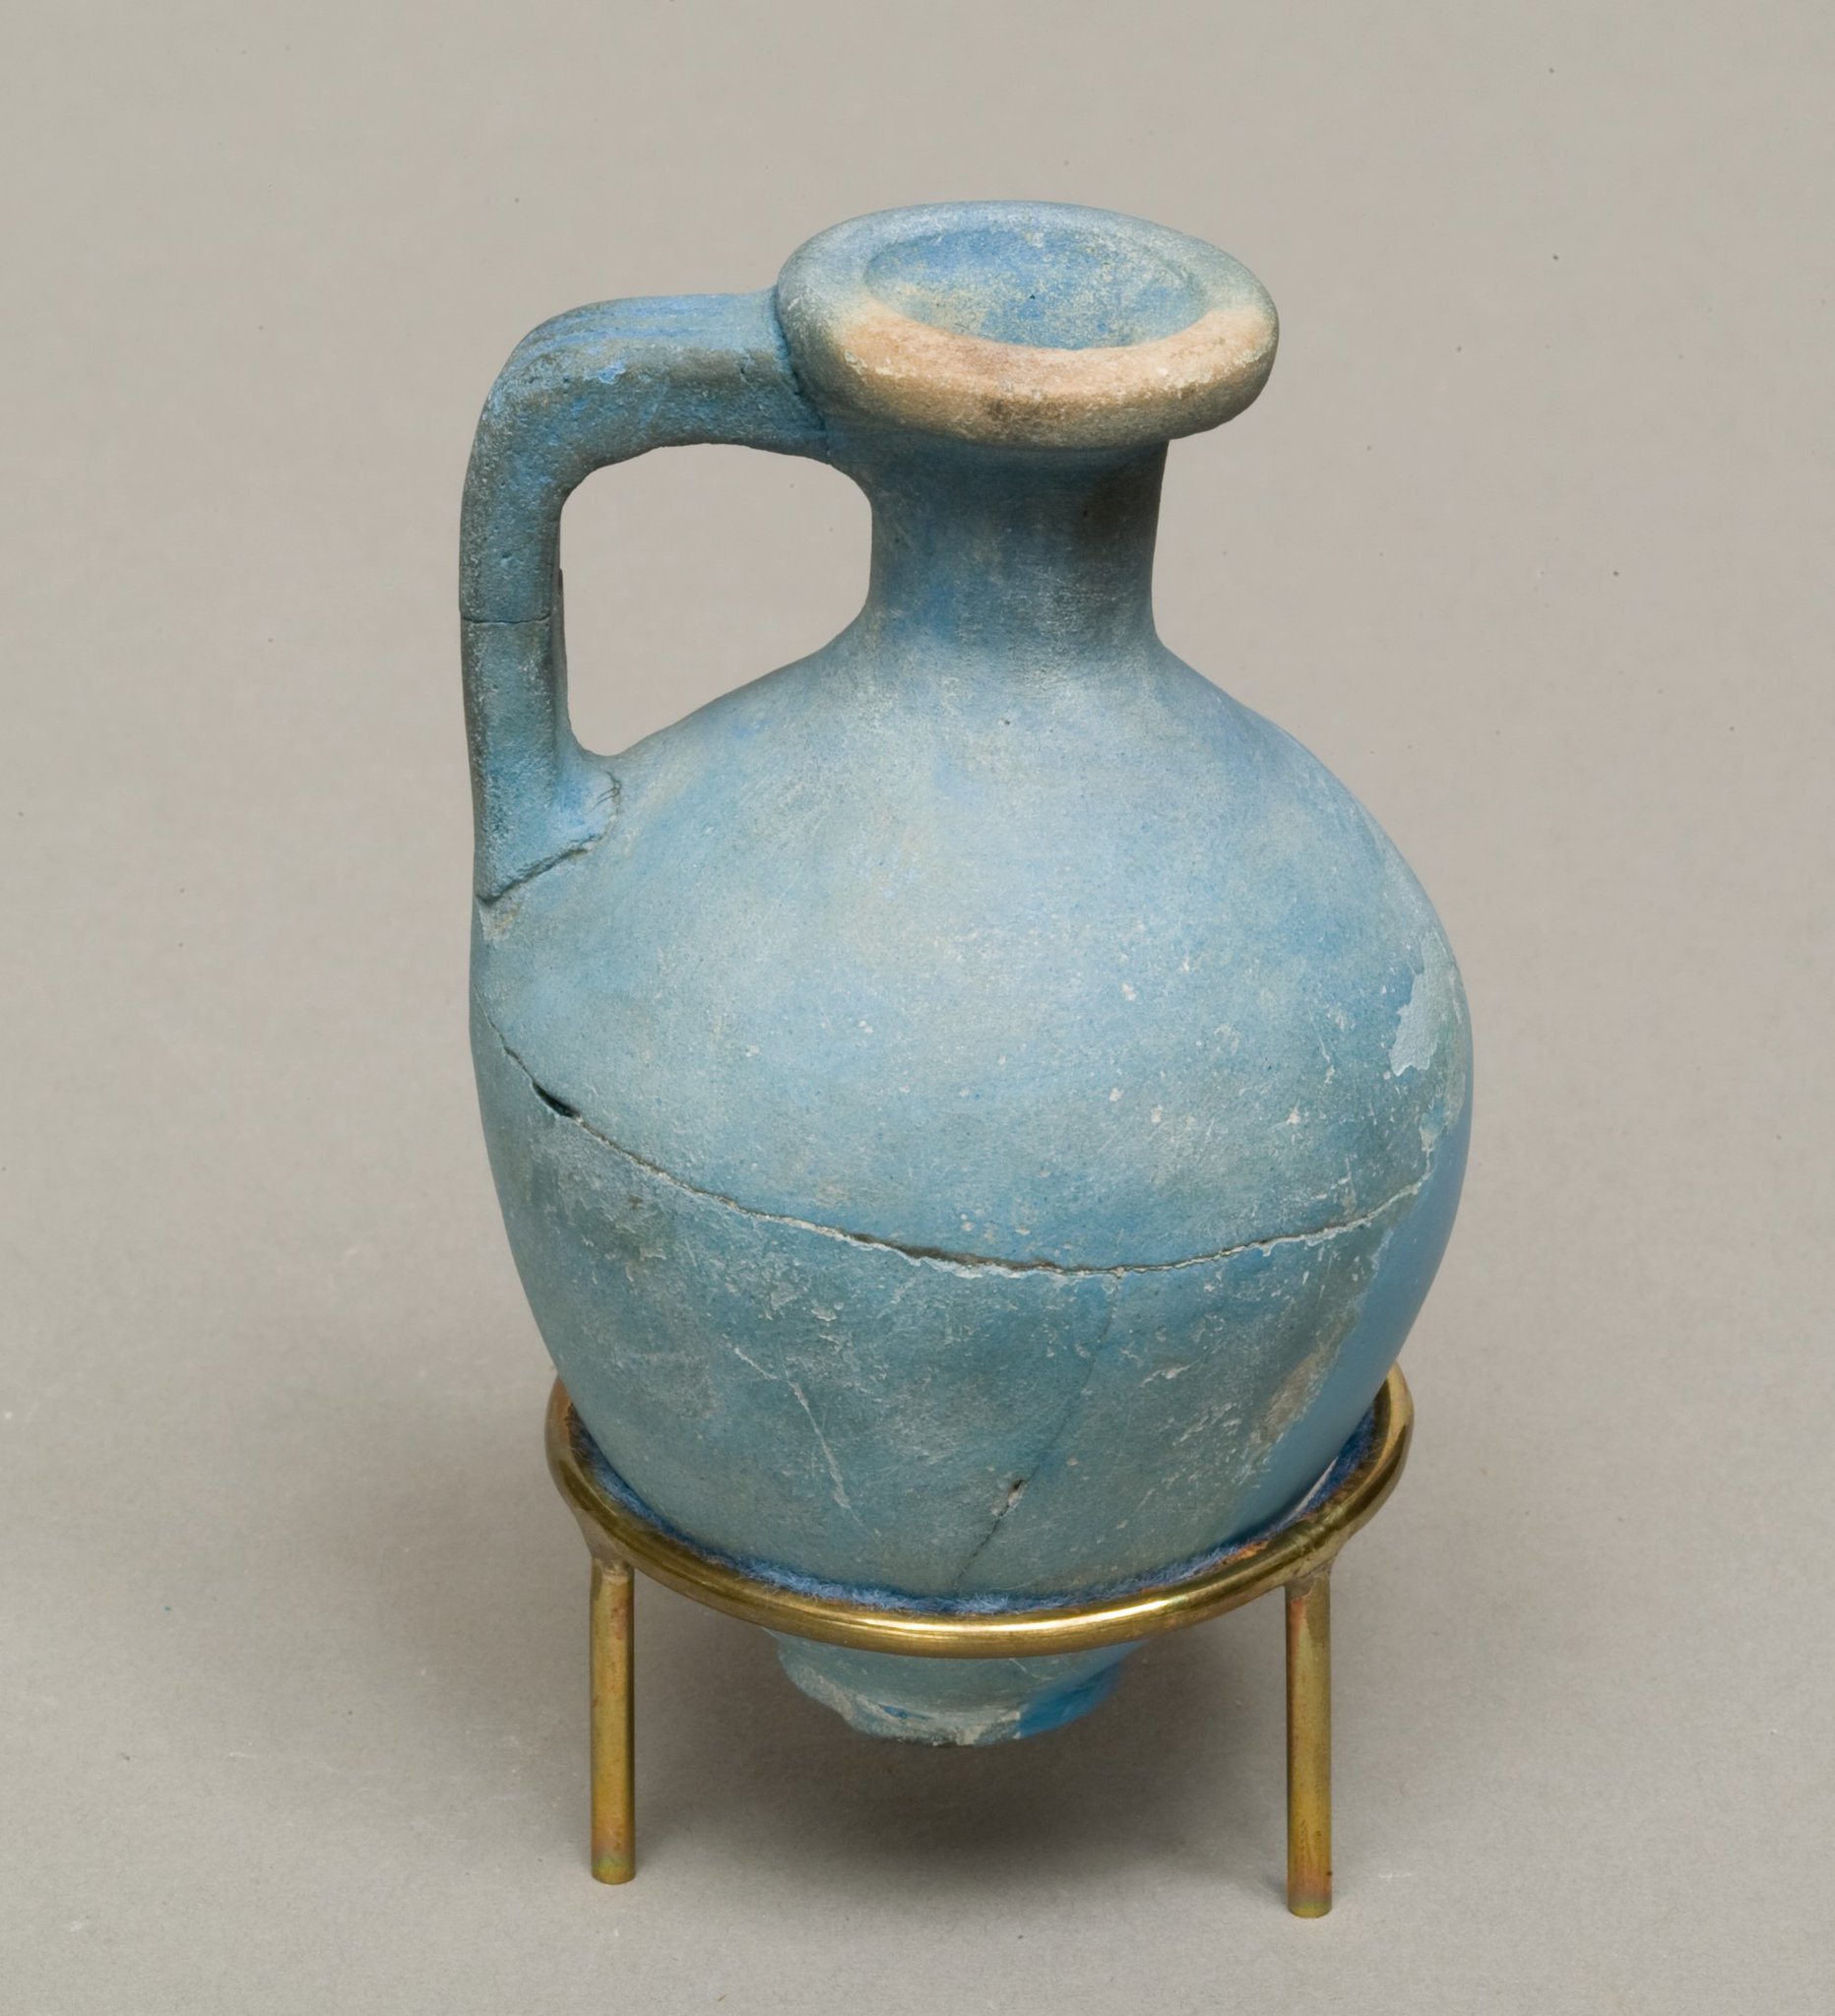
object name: juglet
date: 1750-1640 BCE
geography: egypt